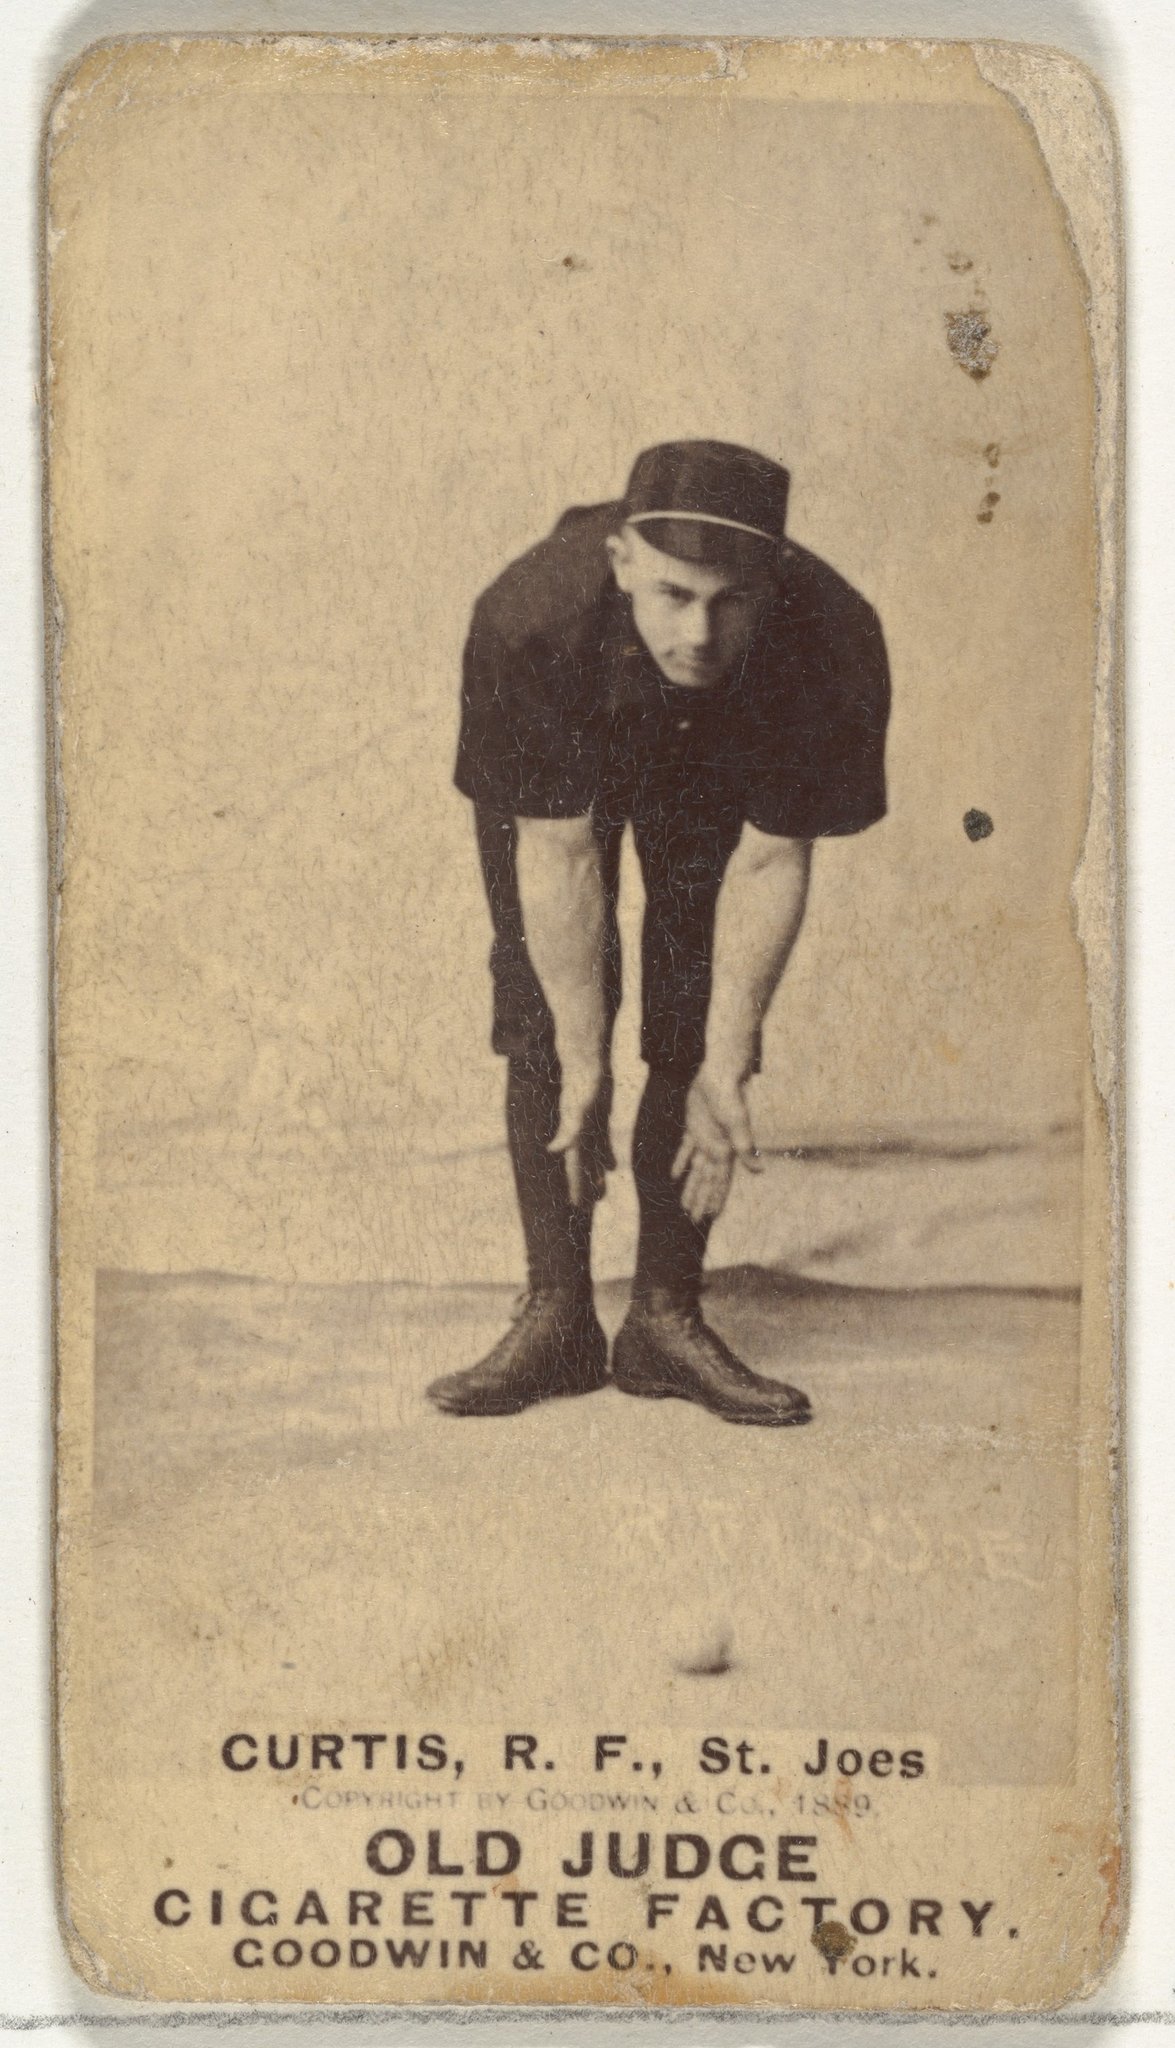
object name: baseball card, photograph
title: Ervin Duane "Jim" Curtiss, Right Field, St. Joseph Clay Eaters, from the Old Judge series (N172) for Old Judge Cigarettes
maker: goodwin & company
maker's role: publisher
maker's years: 1850-1950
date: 1889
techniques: albumen silver print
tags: men,portraits,baseball,athletes